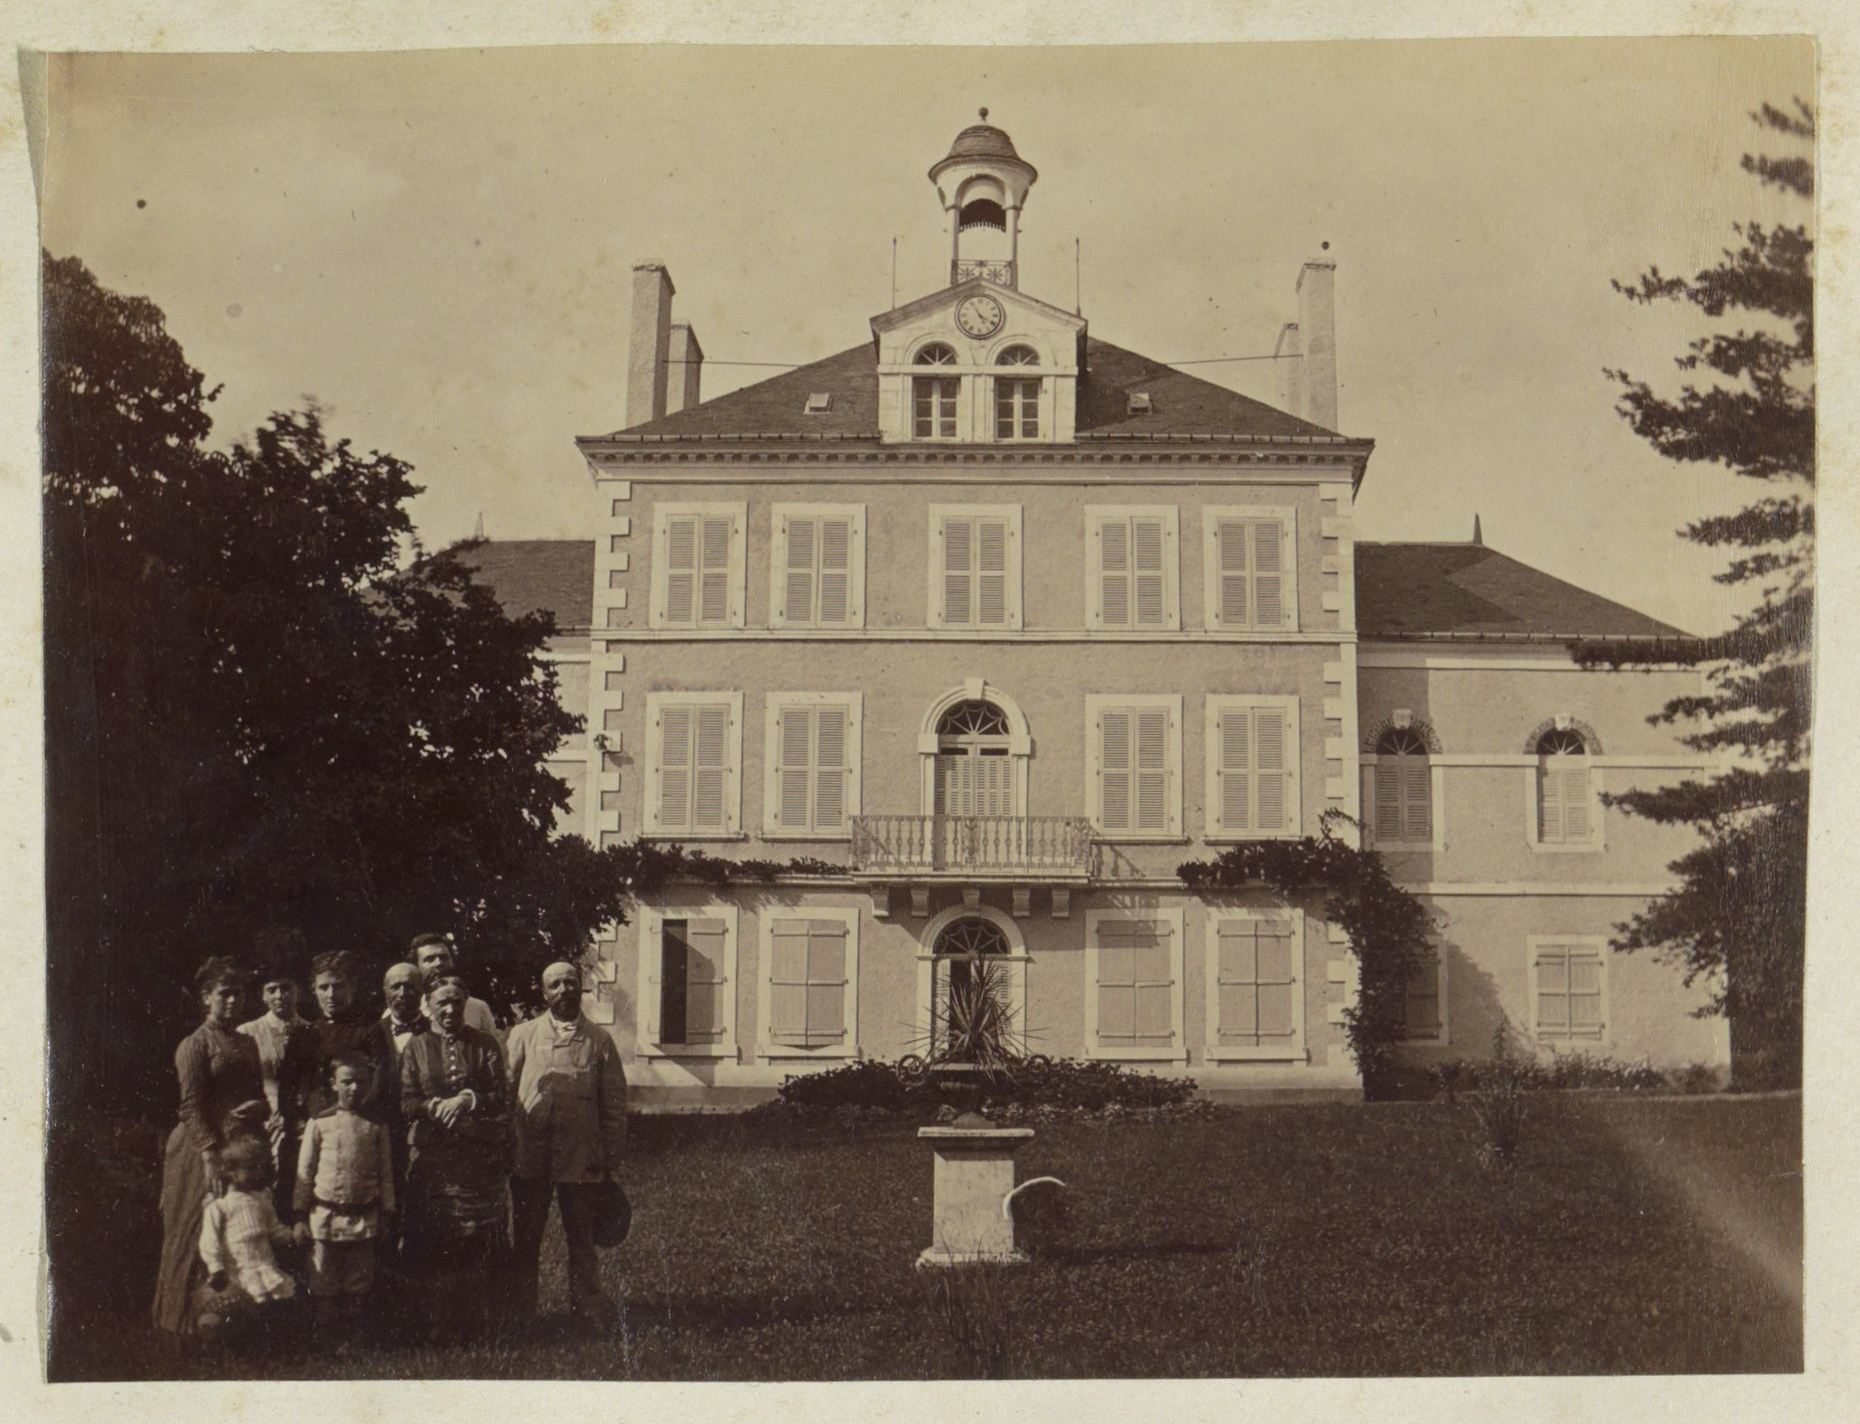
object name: photograph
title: Groepsportret van de familie Corzet voor een landhuis in Surin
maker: Anonymous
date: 1807-1885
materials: photographic support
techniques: albumen print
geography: surin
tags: family group, especially parents with their child(ren), rural housing, e.g. country-house, villa, cottage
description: Onderdeel van Album van een Franse amateurfotograaf met opnames van familie, militairen, industrie, landschappen en bezienswaardigheden in Frankrijk.